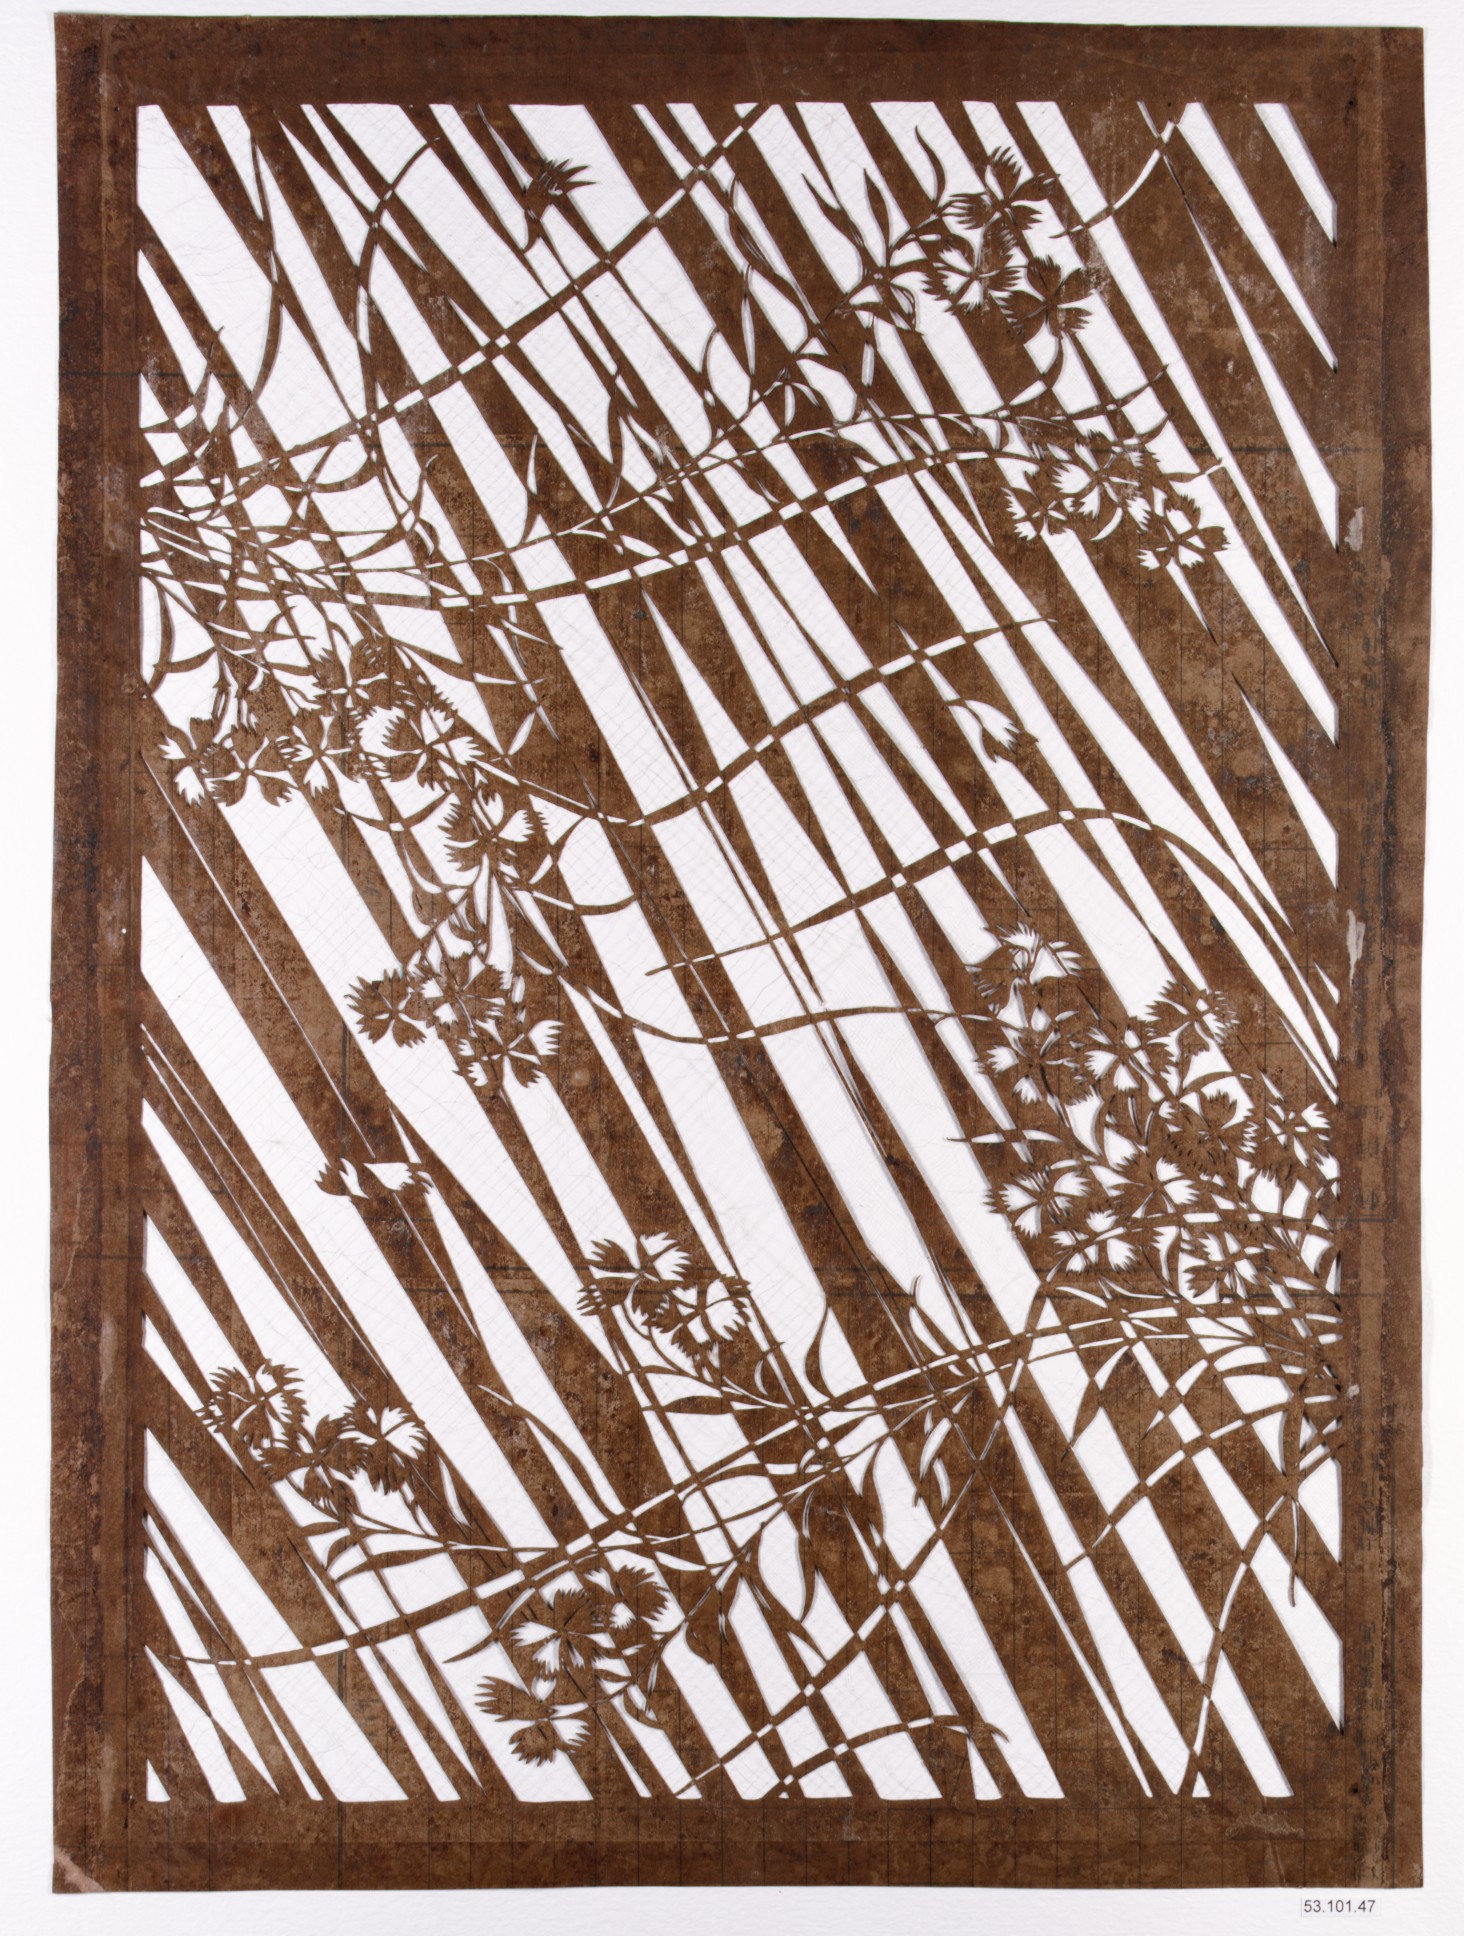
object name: stencil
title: Stencil with Pattern of Pinks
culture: japanese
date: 1801-1900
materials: paper, silk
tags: flowers